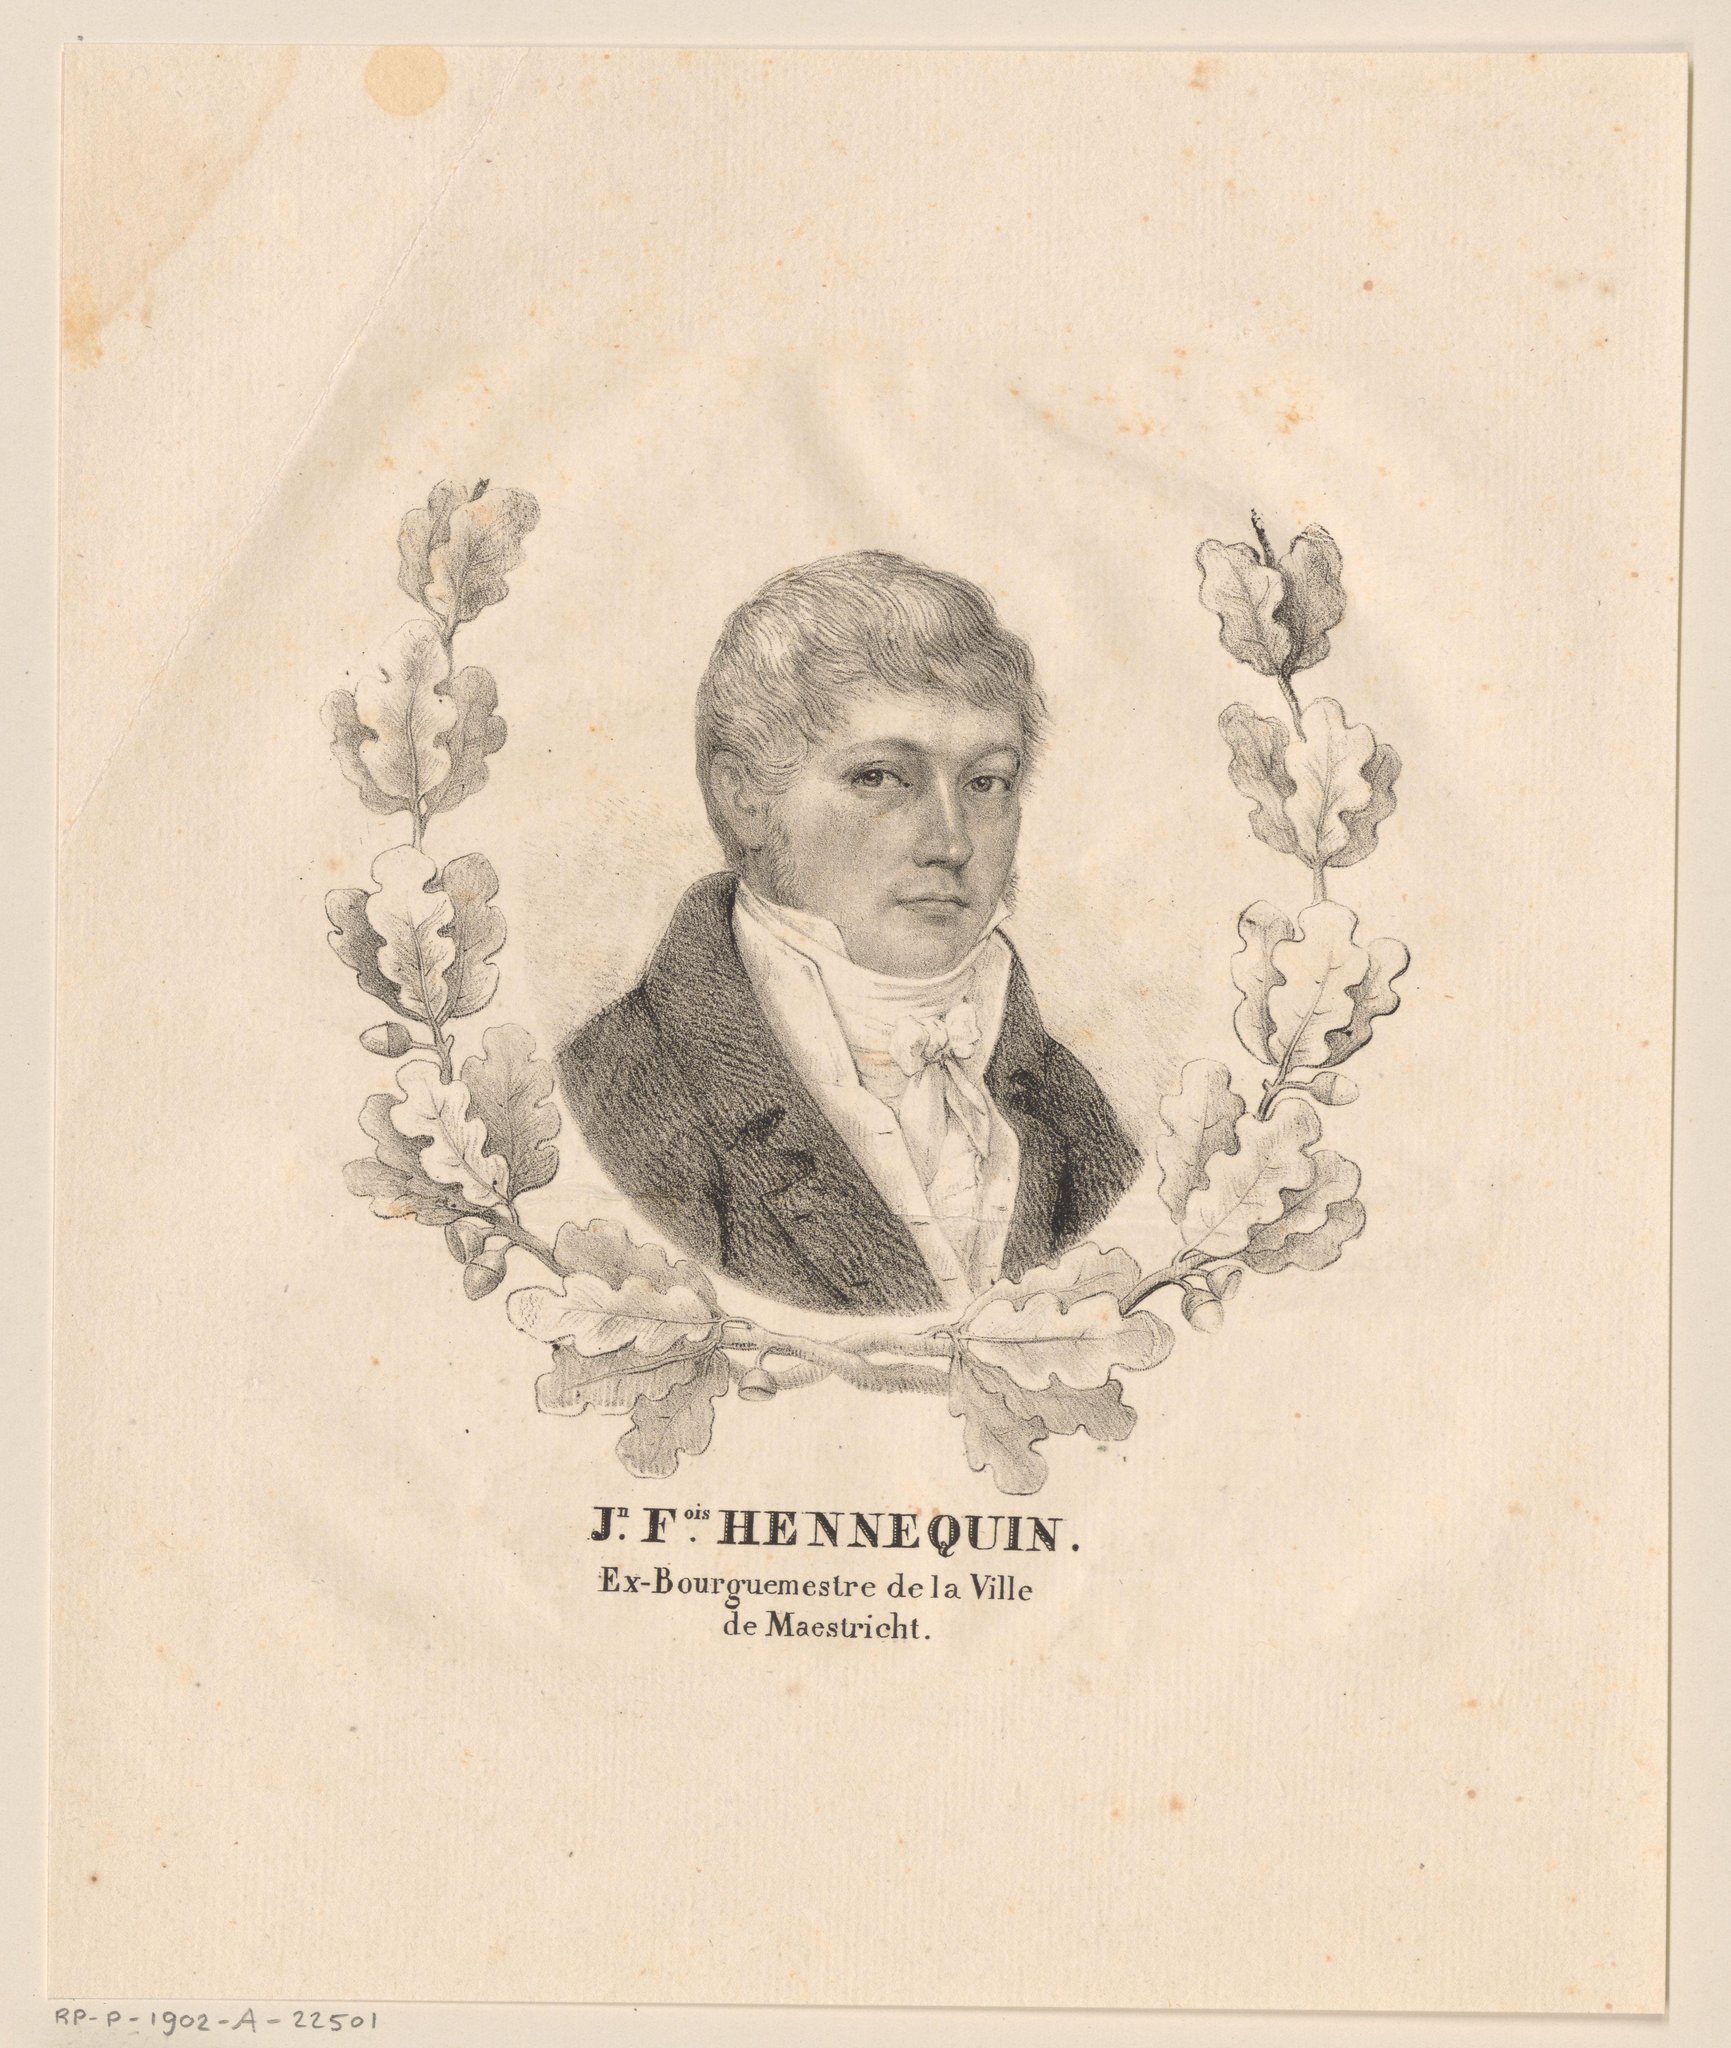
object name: print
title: Portret van Jean François Hennequin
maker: Anonymous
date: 1831-1849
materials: paper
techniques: lithograph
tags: politician, mayor, mayor, burgomaster, historical persons, trees: oak